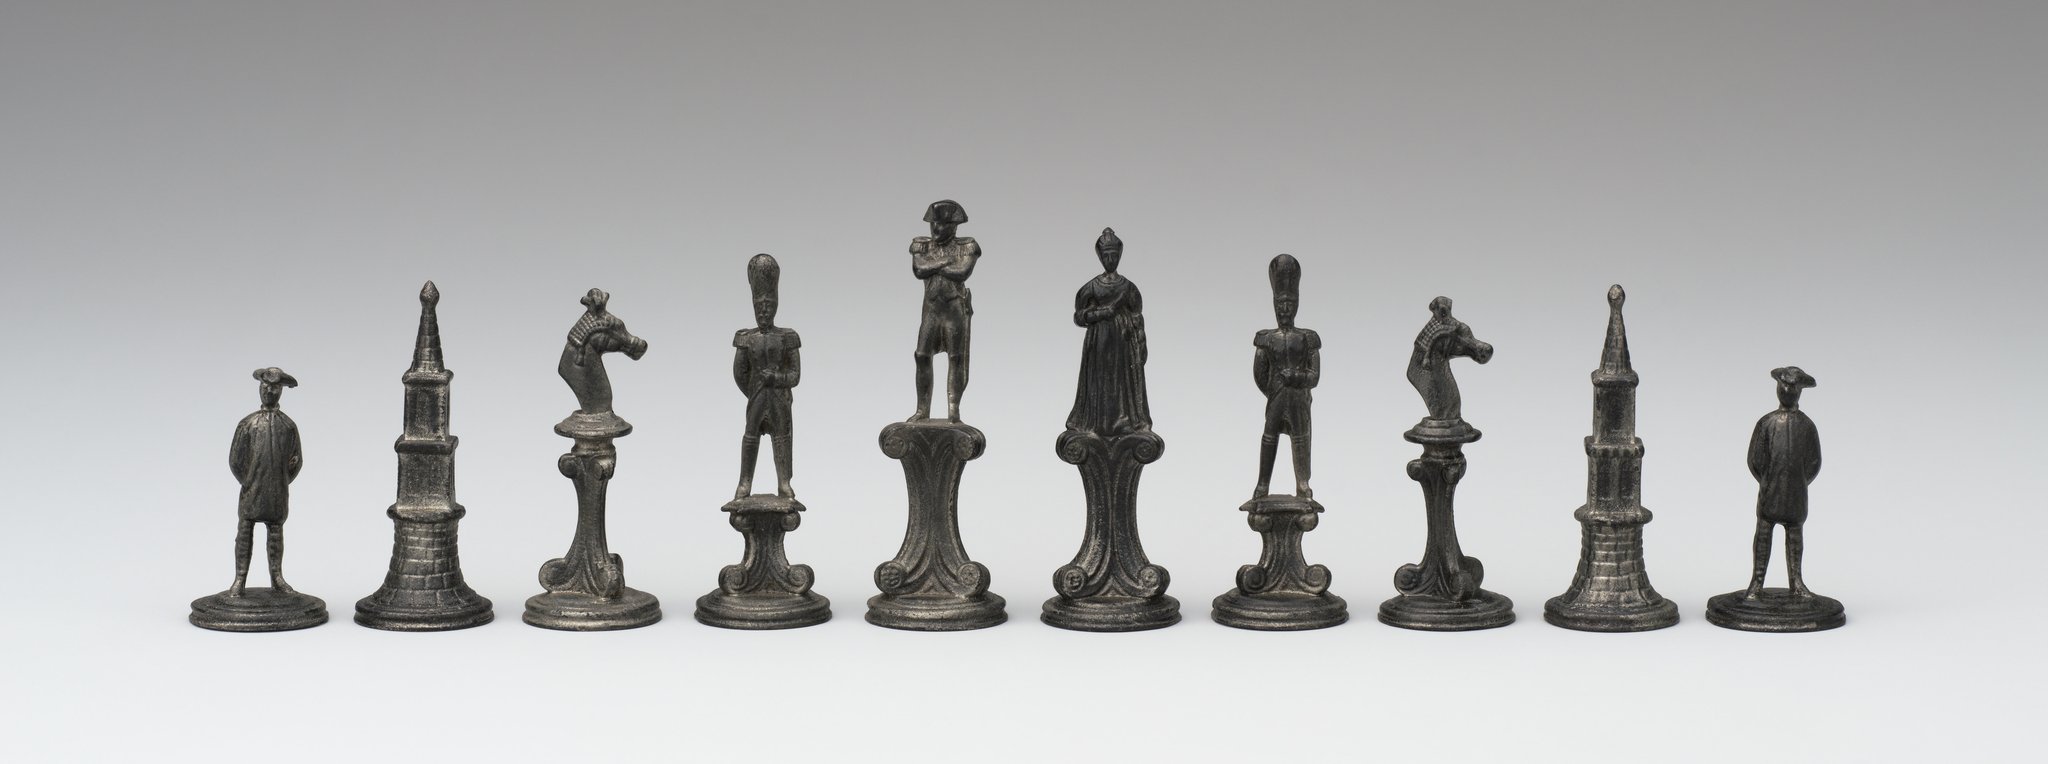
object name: chessman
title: Chessmen (32)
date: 1801-1900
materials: iron